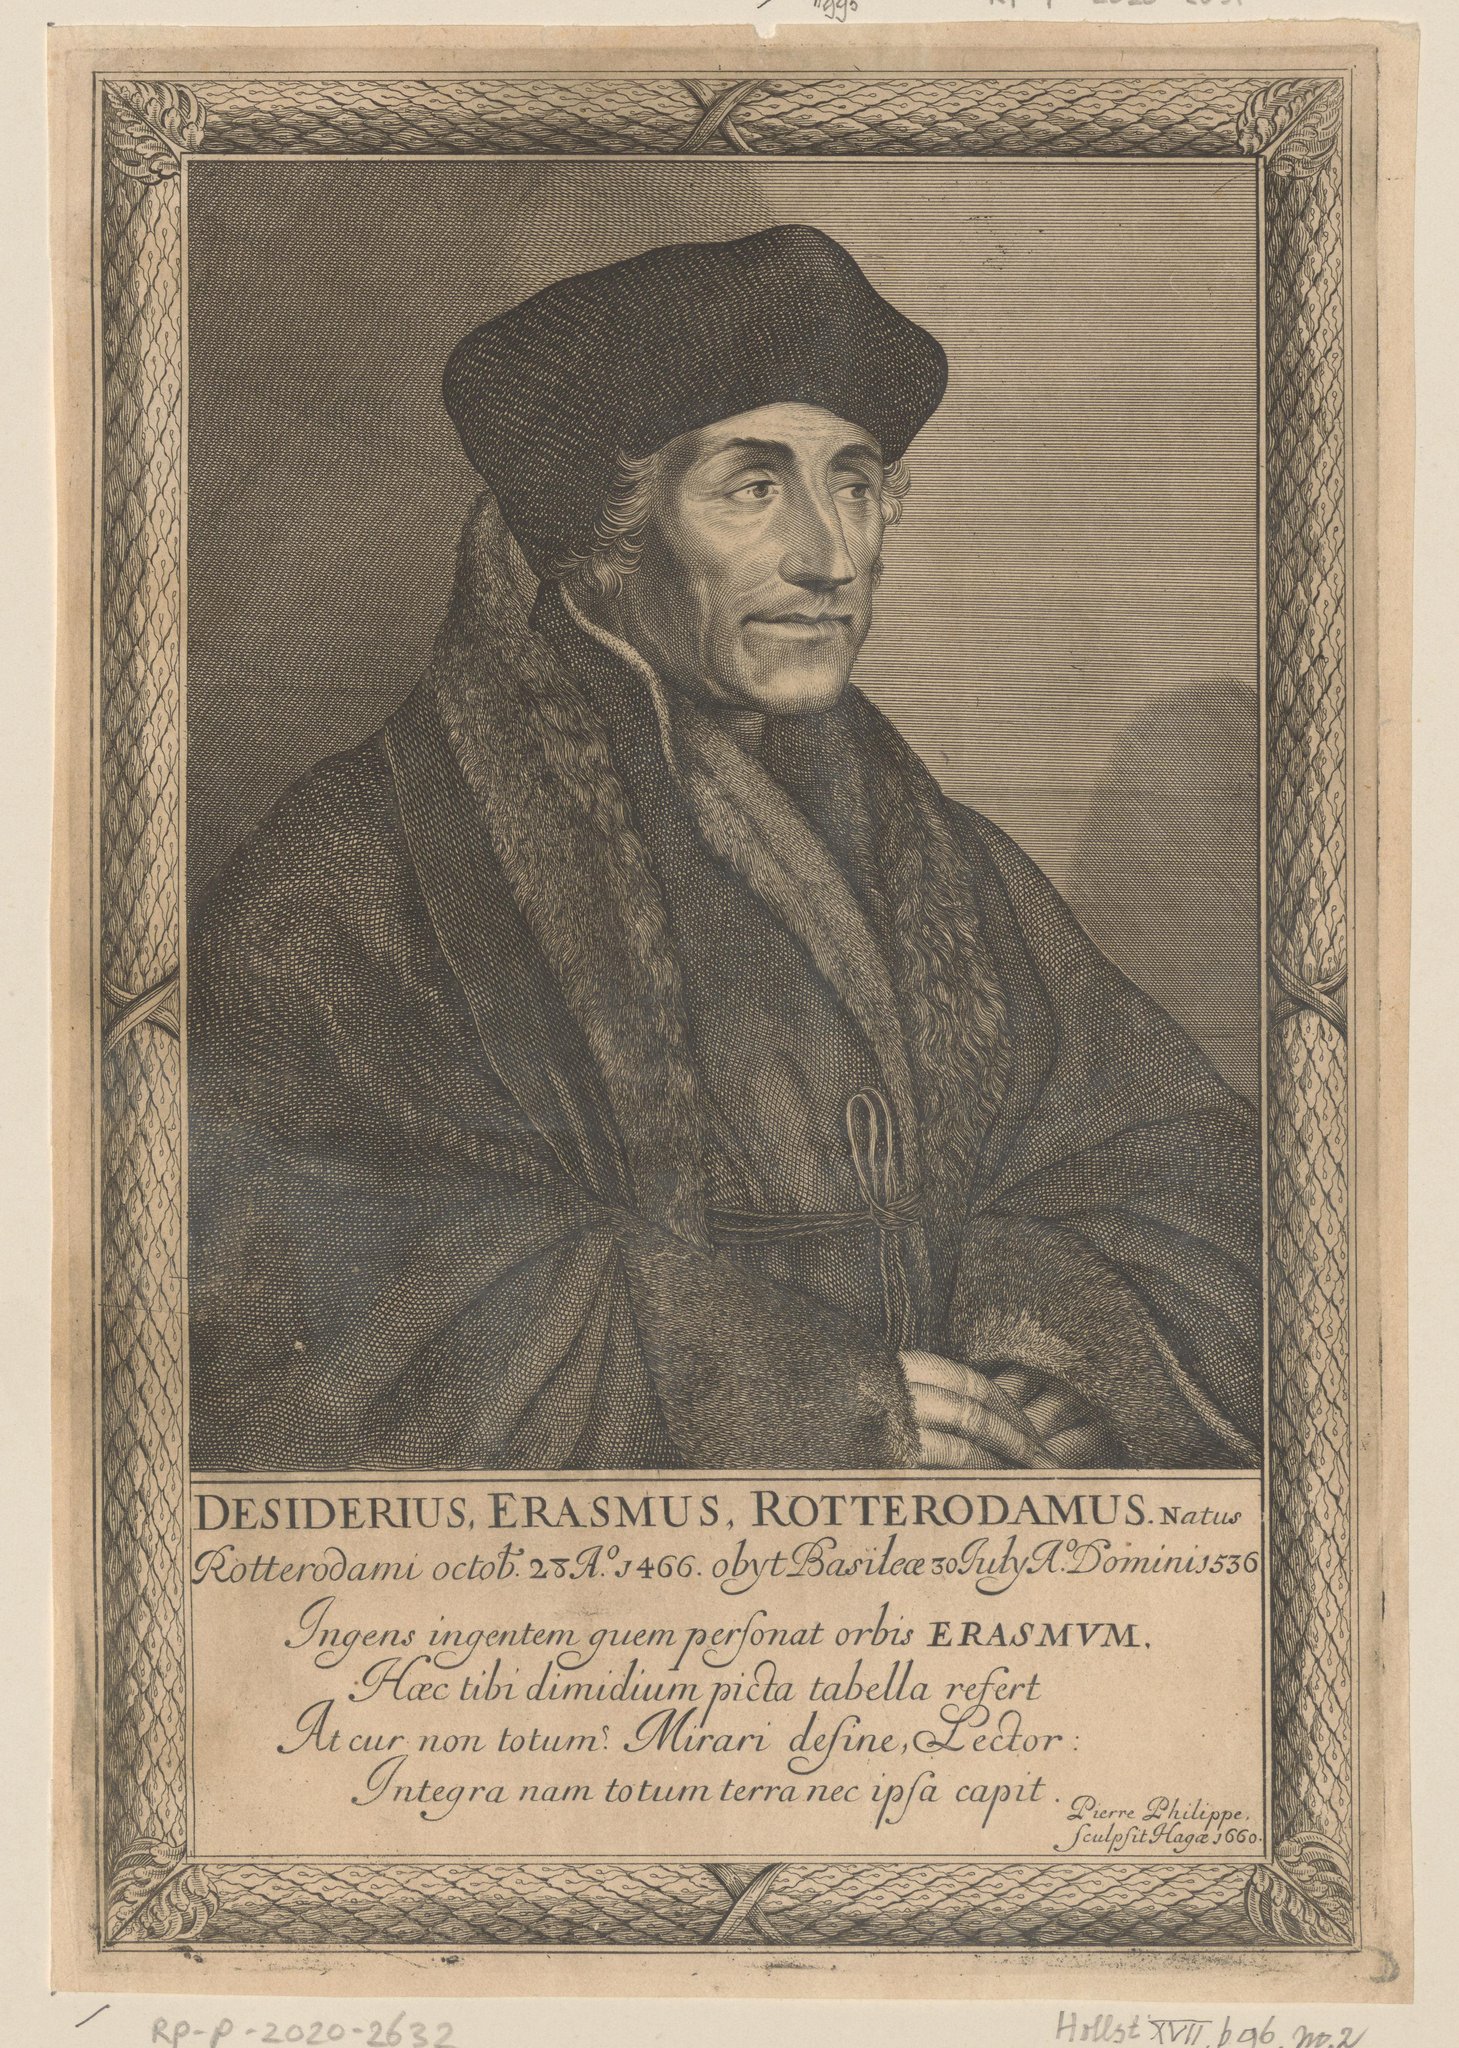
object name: print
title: Portret van Desiderius Erasmus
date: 1660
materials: paper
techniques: engraving, etching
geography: the hague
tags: rotterdam, desiderius erasmus, historical persons, scholar, philosopher (+ portrait of scholar, scientist)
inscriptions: date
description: Met vierregelig vers van Beza in het Latijn onder het portret.